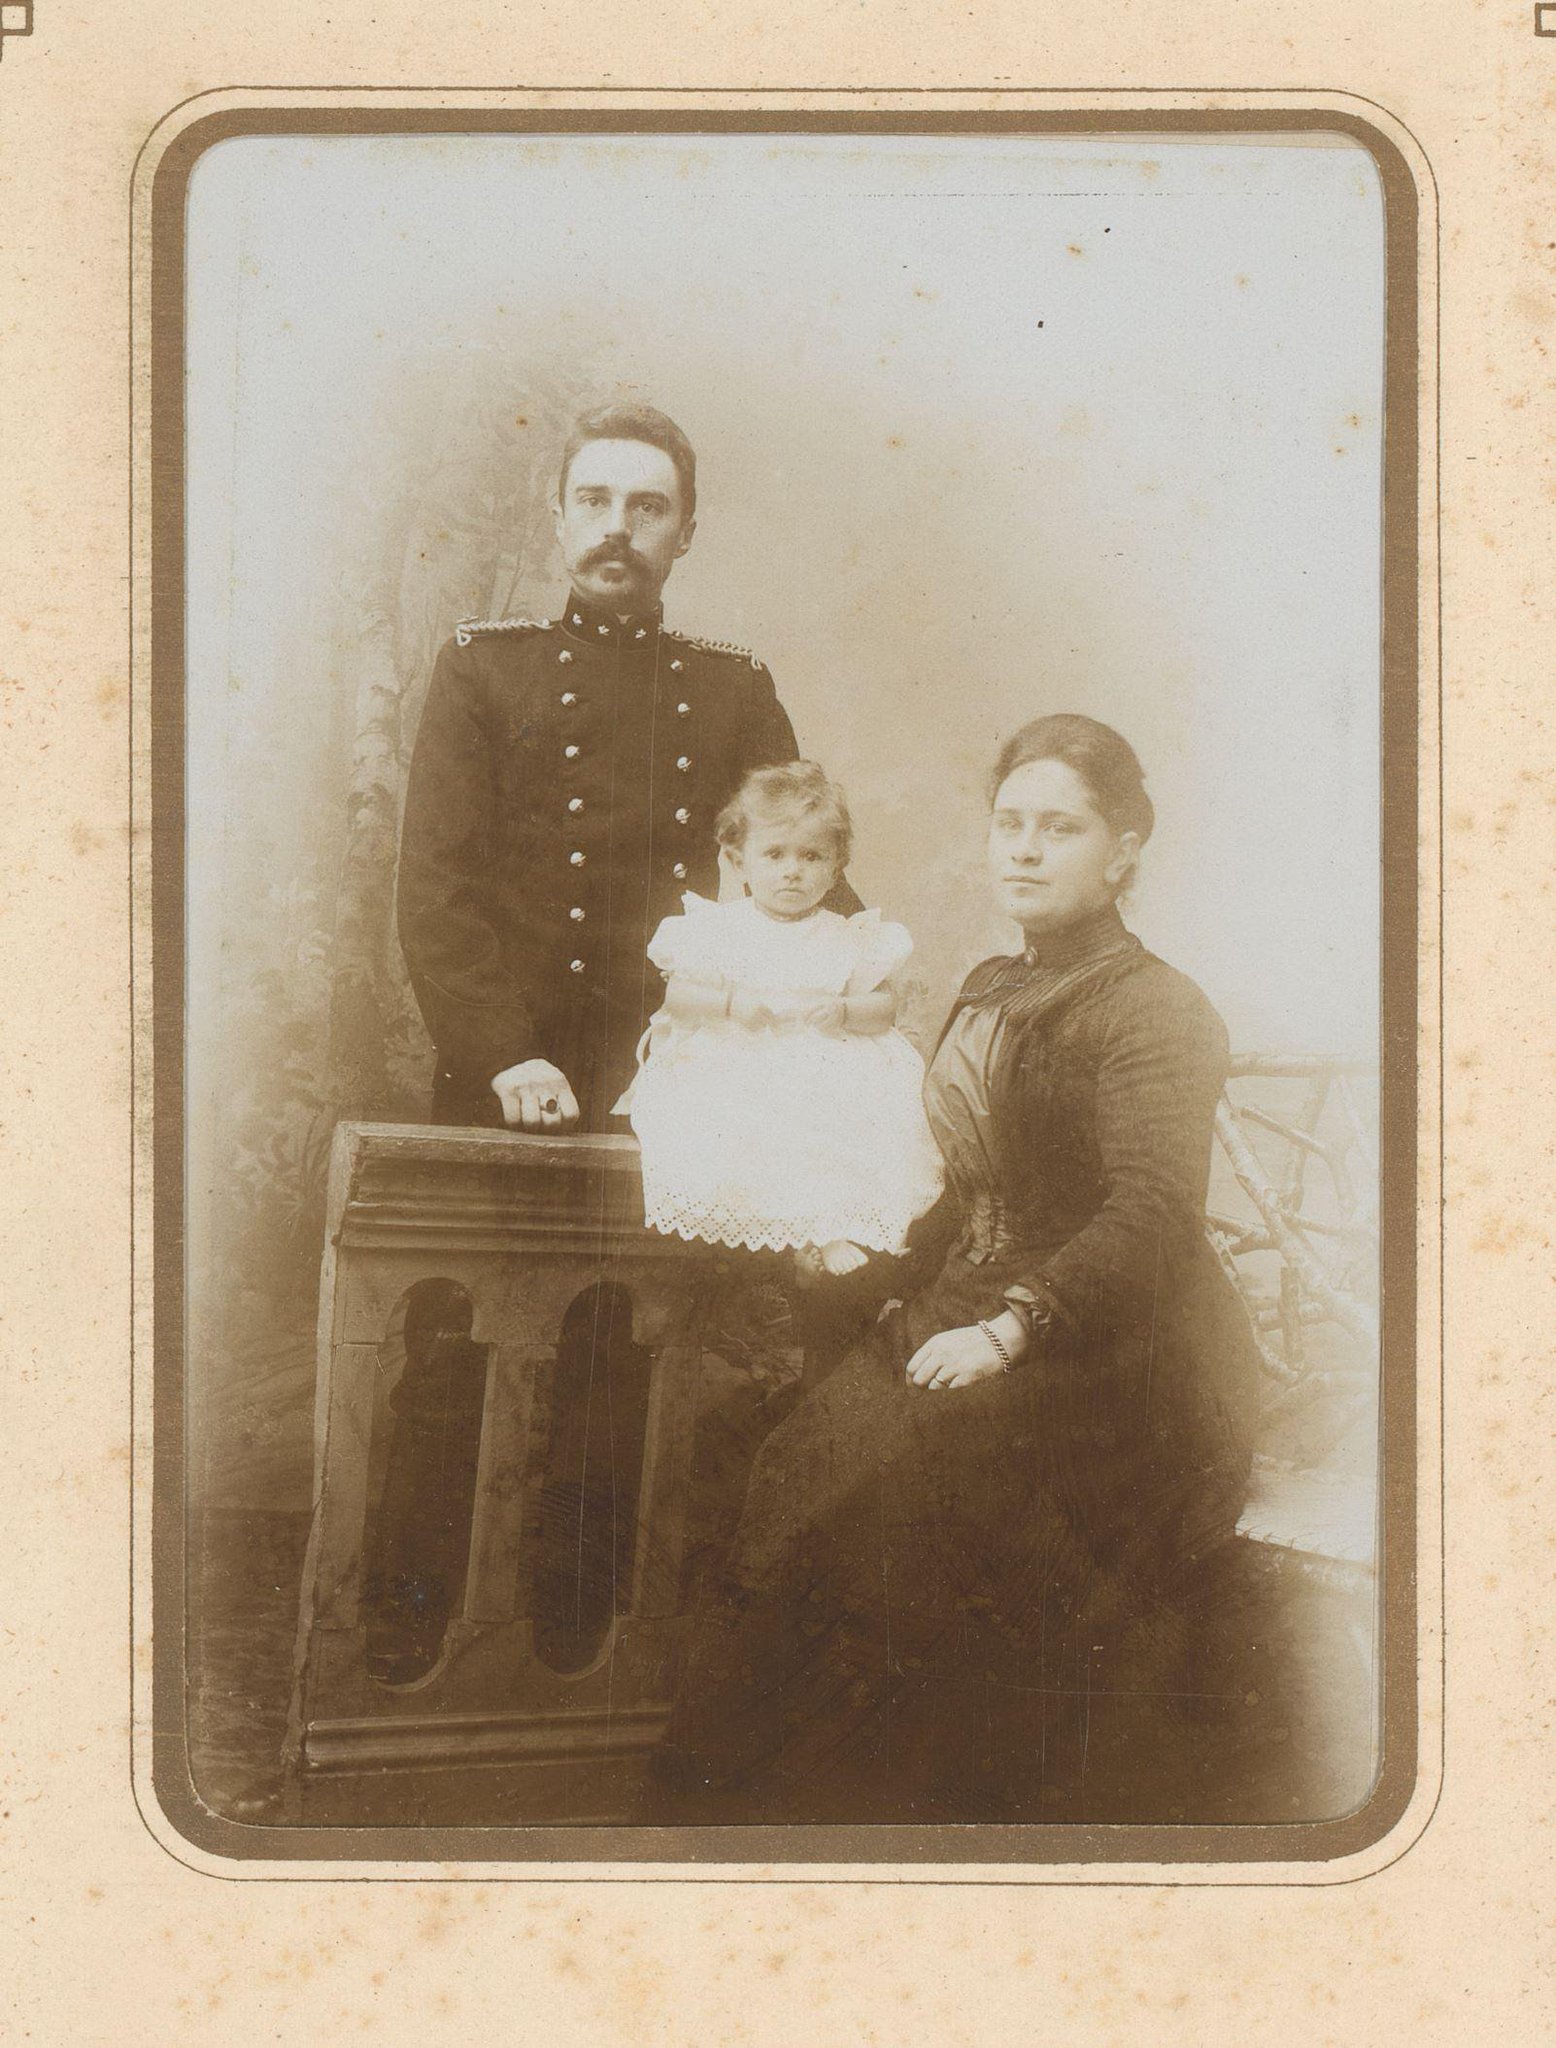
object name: album leaf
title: Portret van een man in uniform en een vrouw en kind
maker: theodorus ferdinant van de pol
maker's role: fotograaf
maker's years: 1861-1953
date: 1901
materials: cardboard, photographic support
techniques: collodion silver print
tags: parents with their children, historical persons, (military) uniforms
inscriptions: inscription: ‘TH. F. v.d. Pol/ Amersfoort’, annotation: ‘Van [...]/ [...]/ 1 Nov 1901’